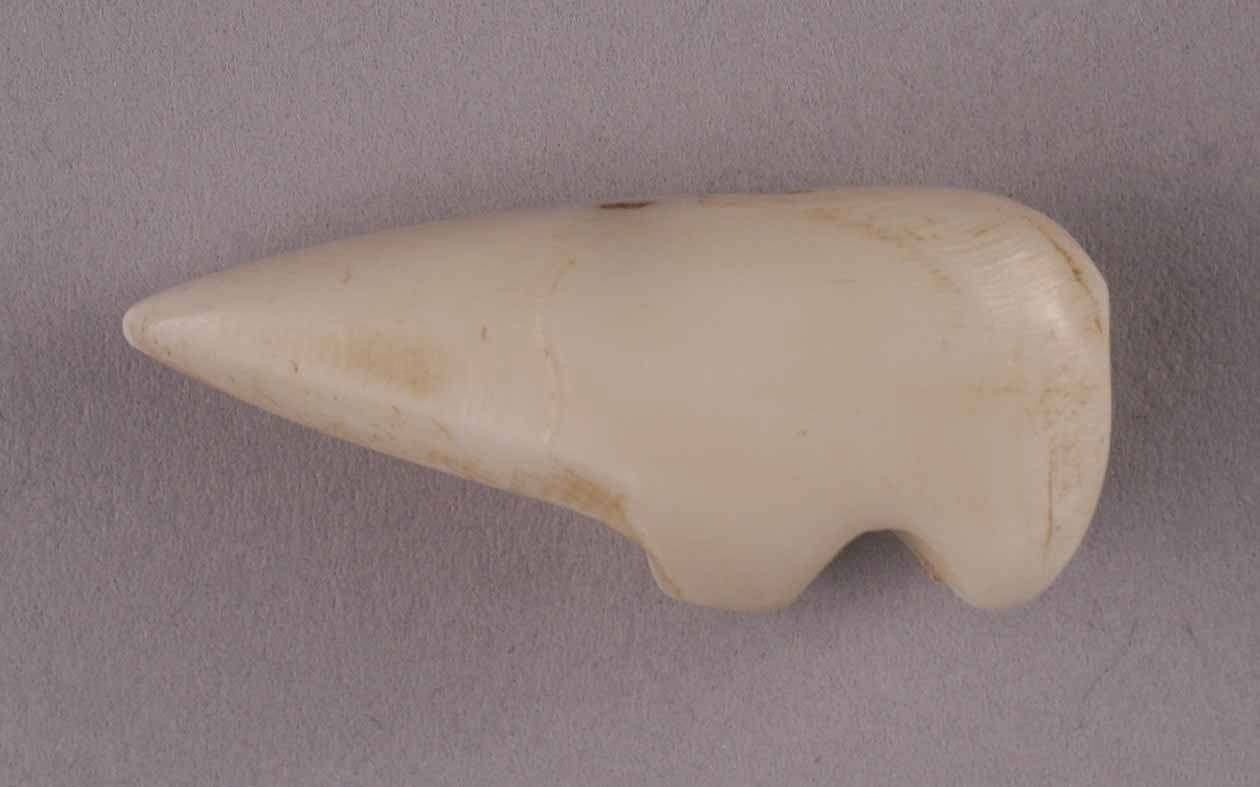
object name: bead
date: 701-1300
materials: bone, ivory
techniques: carving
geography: iran